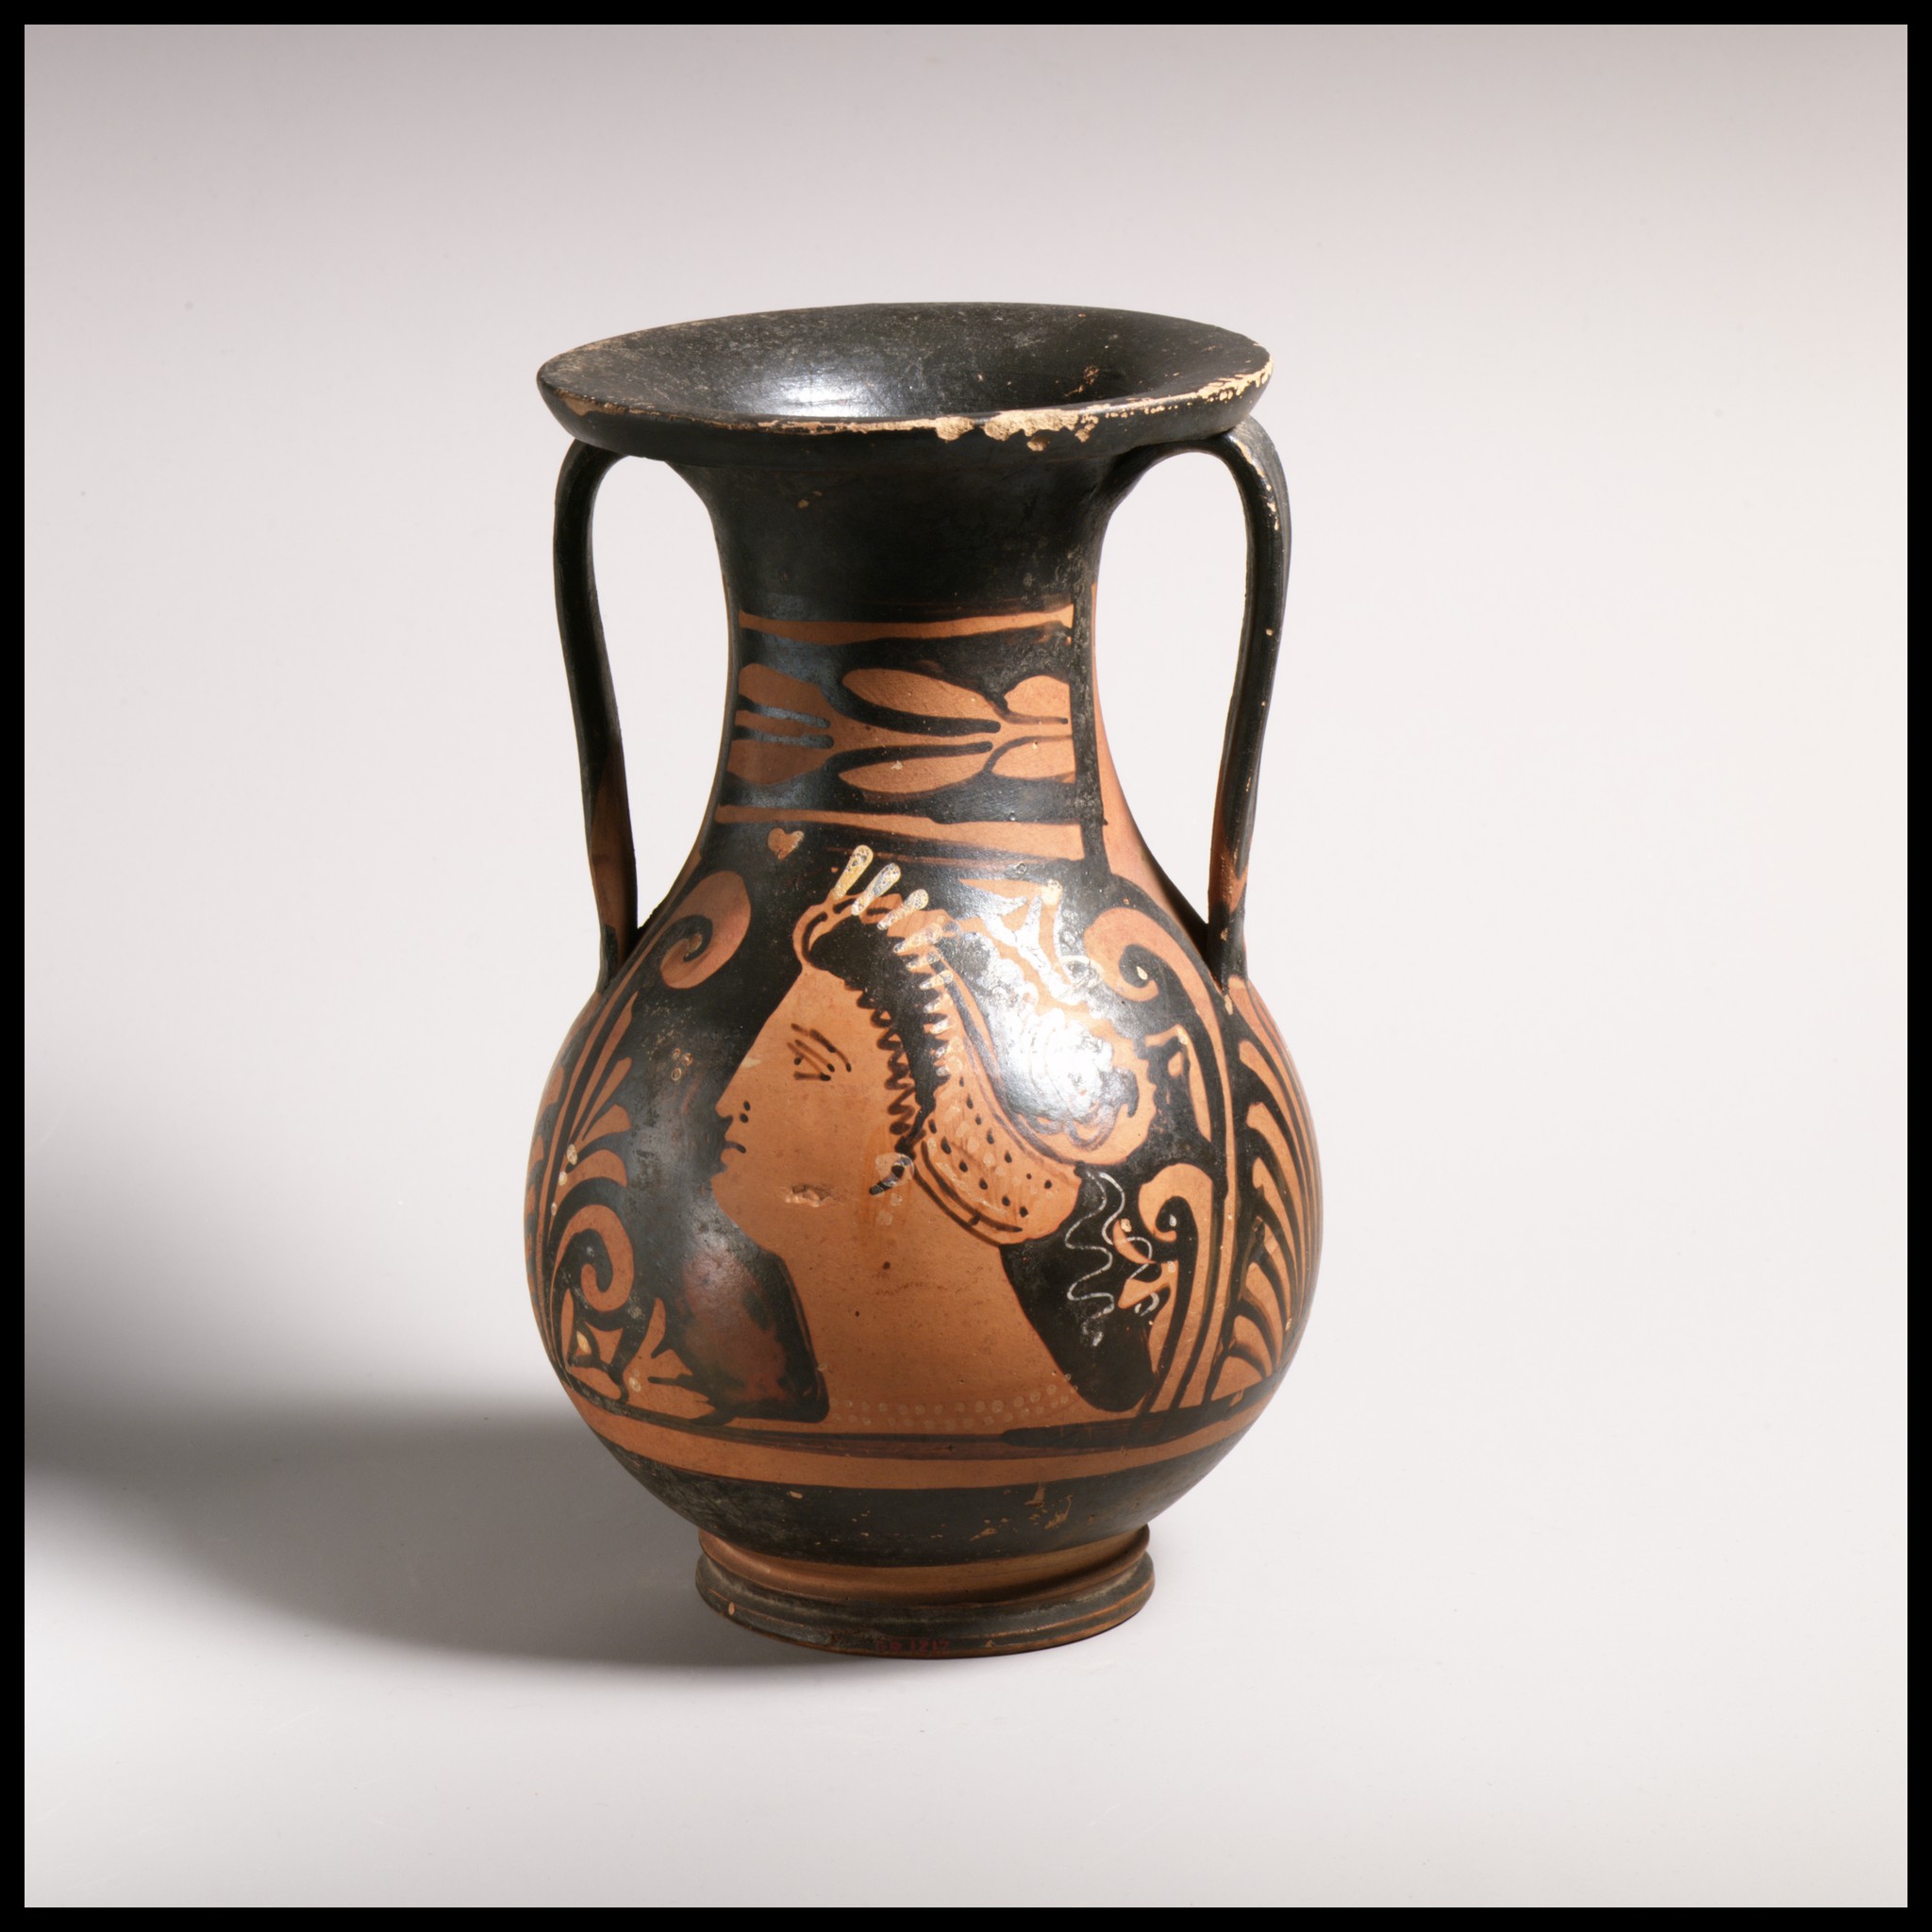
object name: pelike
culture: greek, south italian, apulian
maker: group of zurich 2661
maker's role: artist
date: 350-325 BCE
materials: terracotta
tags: profiles,women